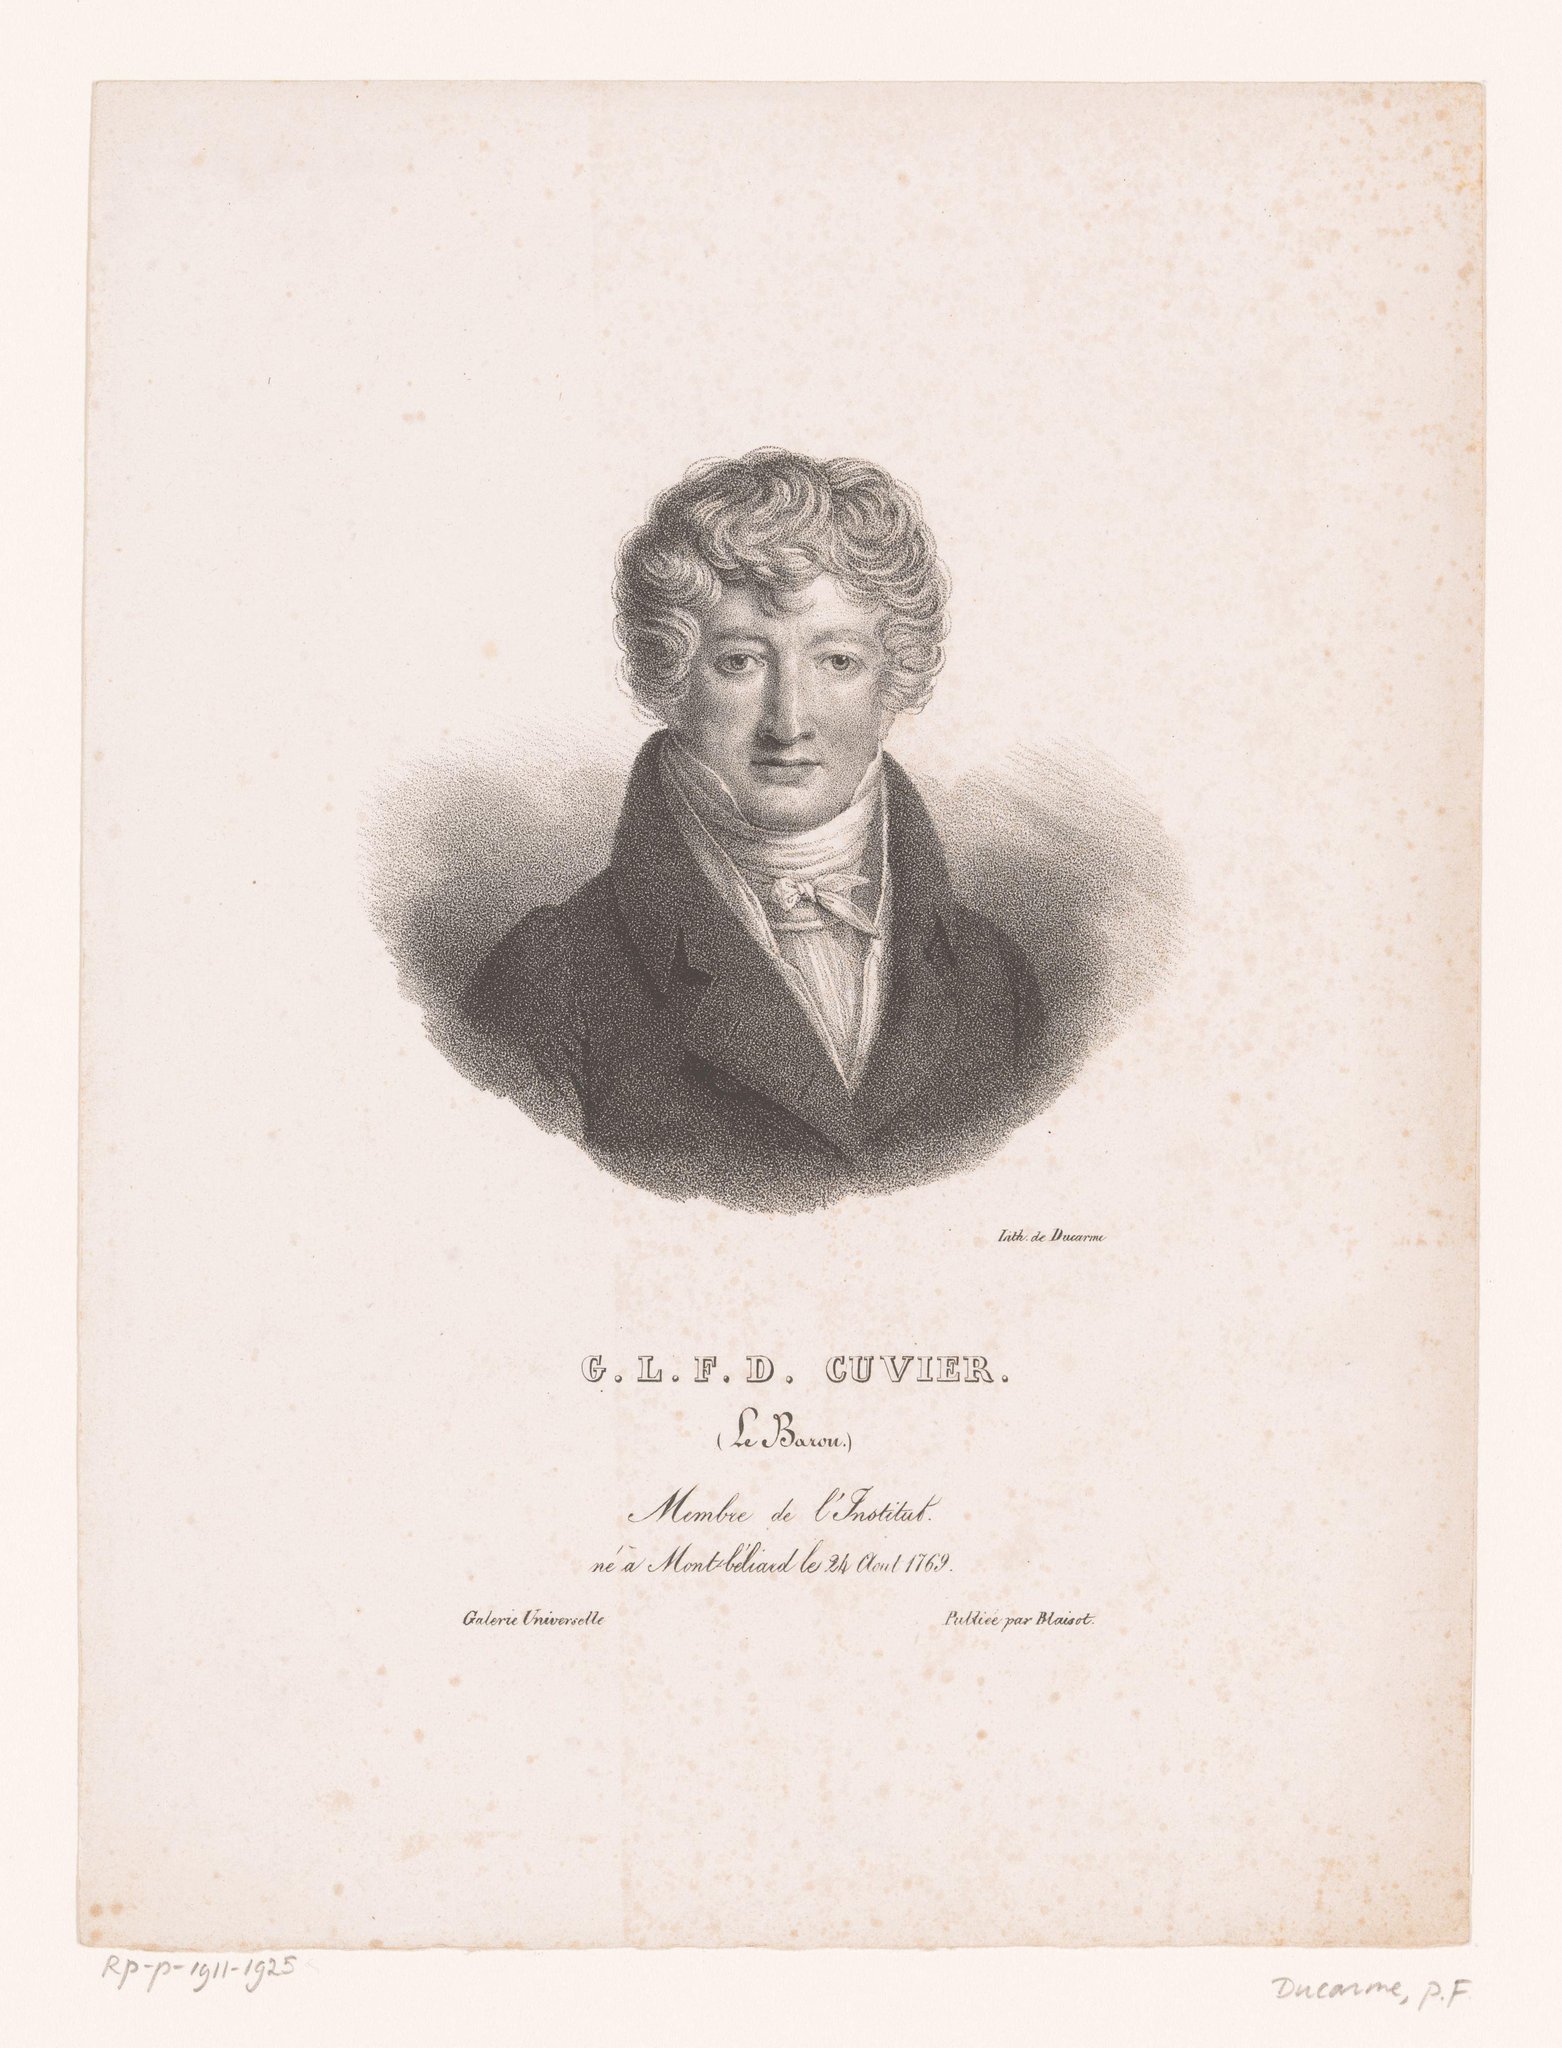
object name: print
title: Portrettengalerij van Blaisot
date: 1820-1829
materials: paper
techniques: lithograph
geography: paris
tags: paris, historical persons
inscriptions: collector's mark: Lugt 2228a